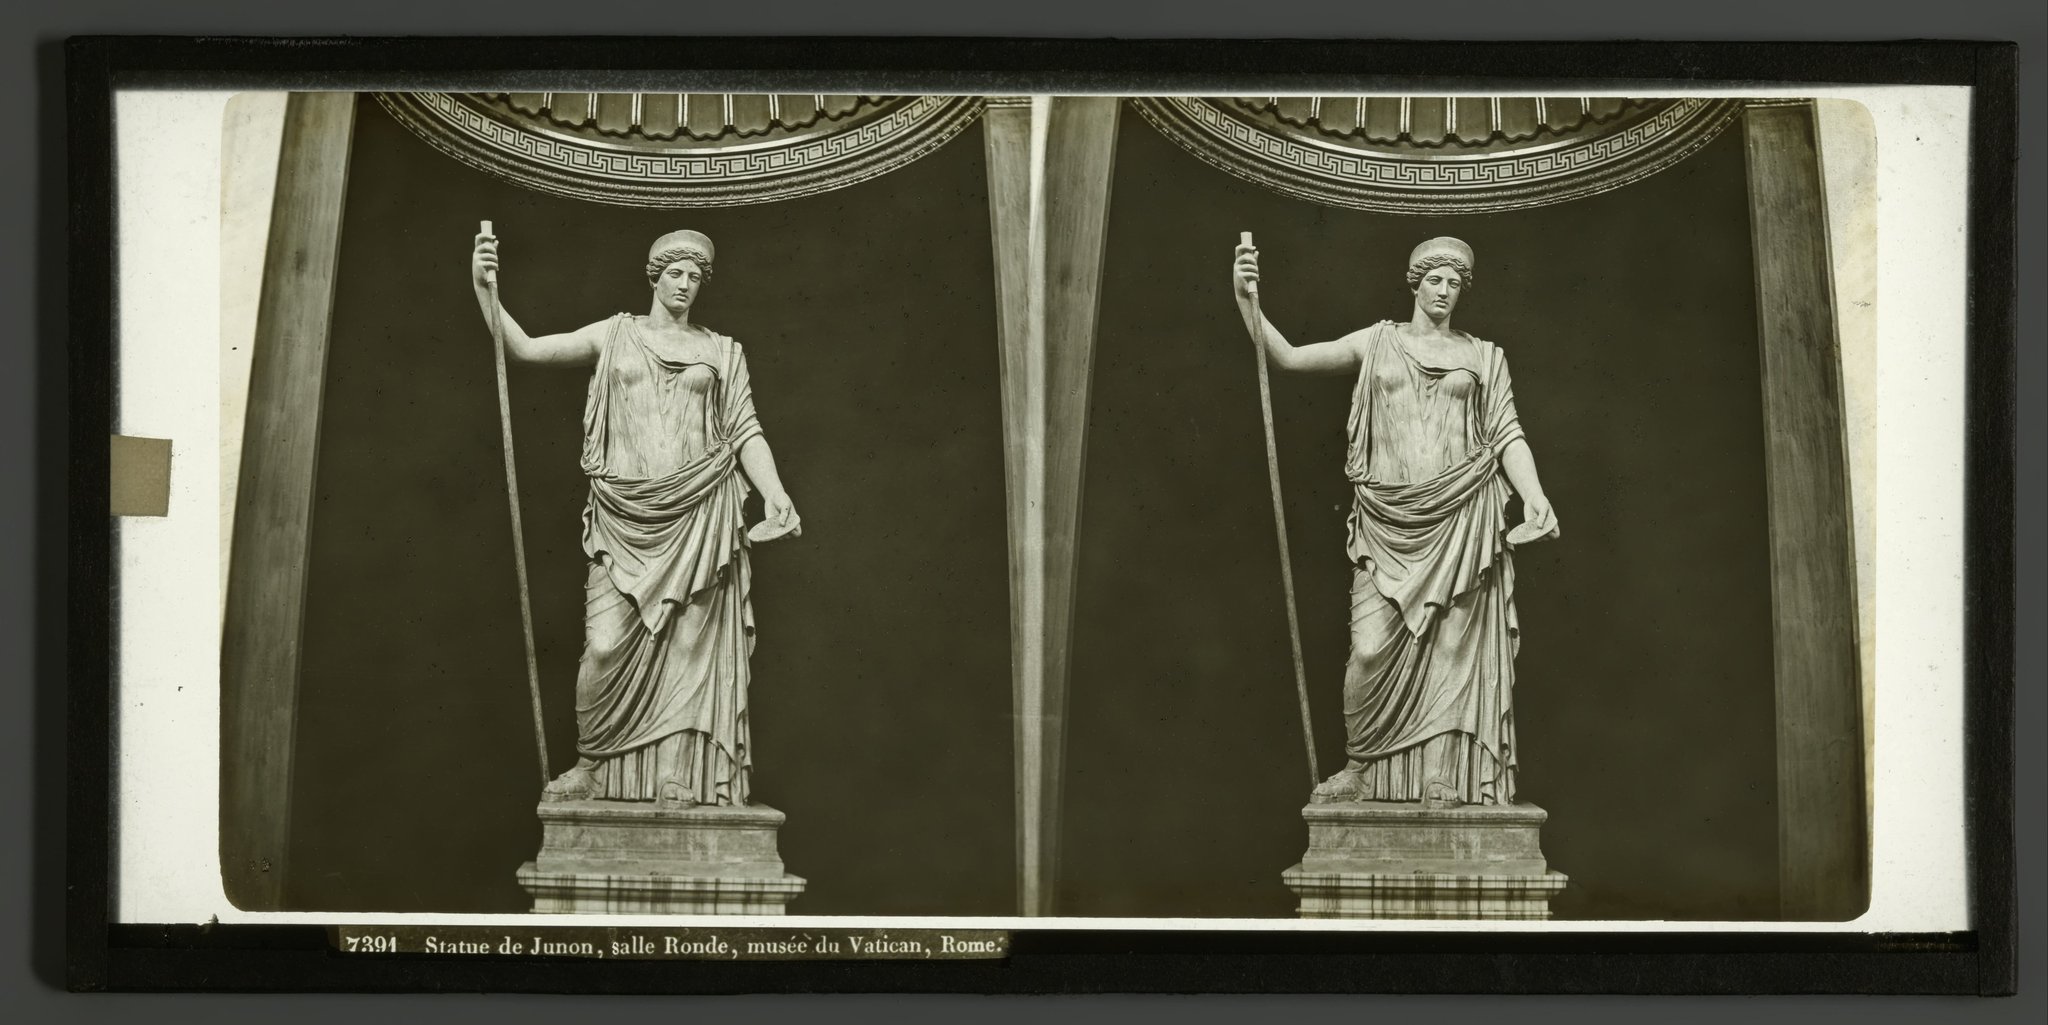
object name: stereoscopic photograph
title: Standbeeld van Juno in het Apostolisch Paleis te Vaticaanstad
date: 1860-1870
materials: glass, paper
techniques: slide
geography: vatican city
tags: (story of) juno (hera), sculpture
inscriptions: inscription: ‘7391 Statue de Junon, salle Ronde, musee du Vatican, Rome’